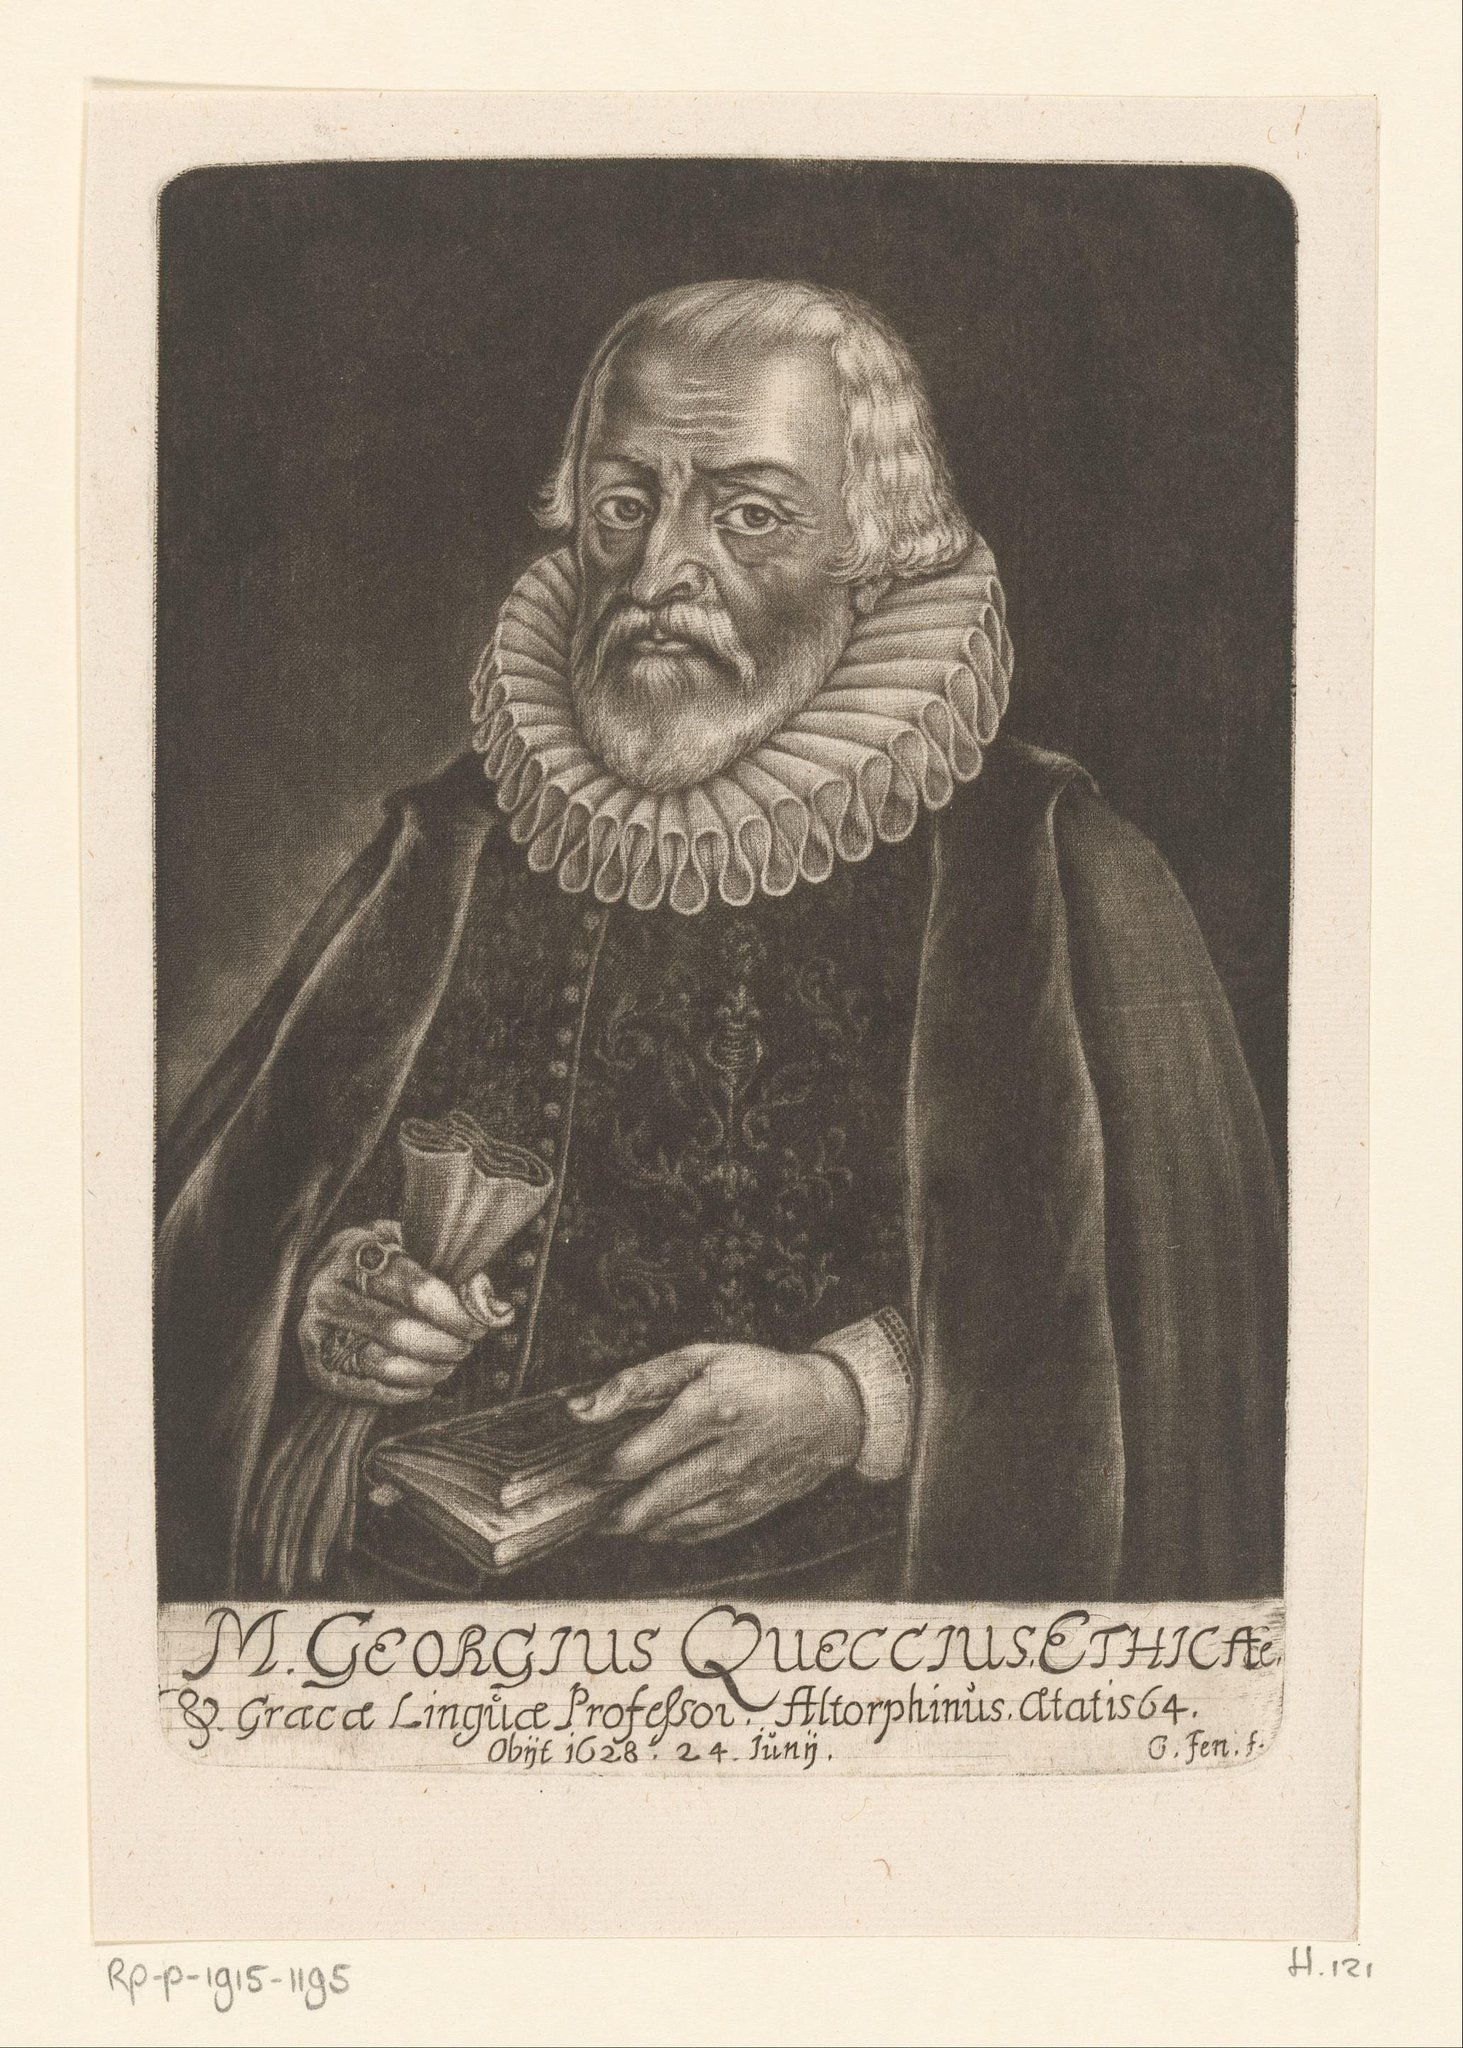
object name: print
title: Portret van Georg Queccius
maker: georg fennitzer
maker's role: print maker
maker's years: 1646-1722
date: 1656-1722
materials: paper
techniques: mezzotint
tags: gloves, mittens, etc., historical persons, book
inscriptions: collector's mark: Lugt 2228